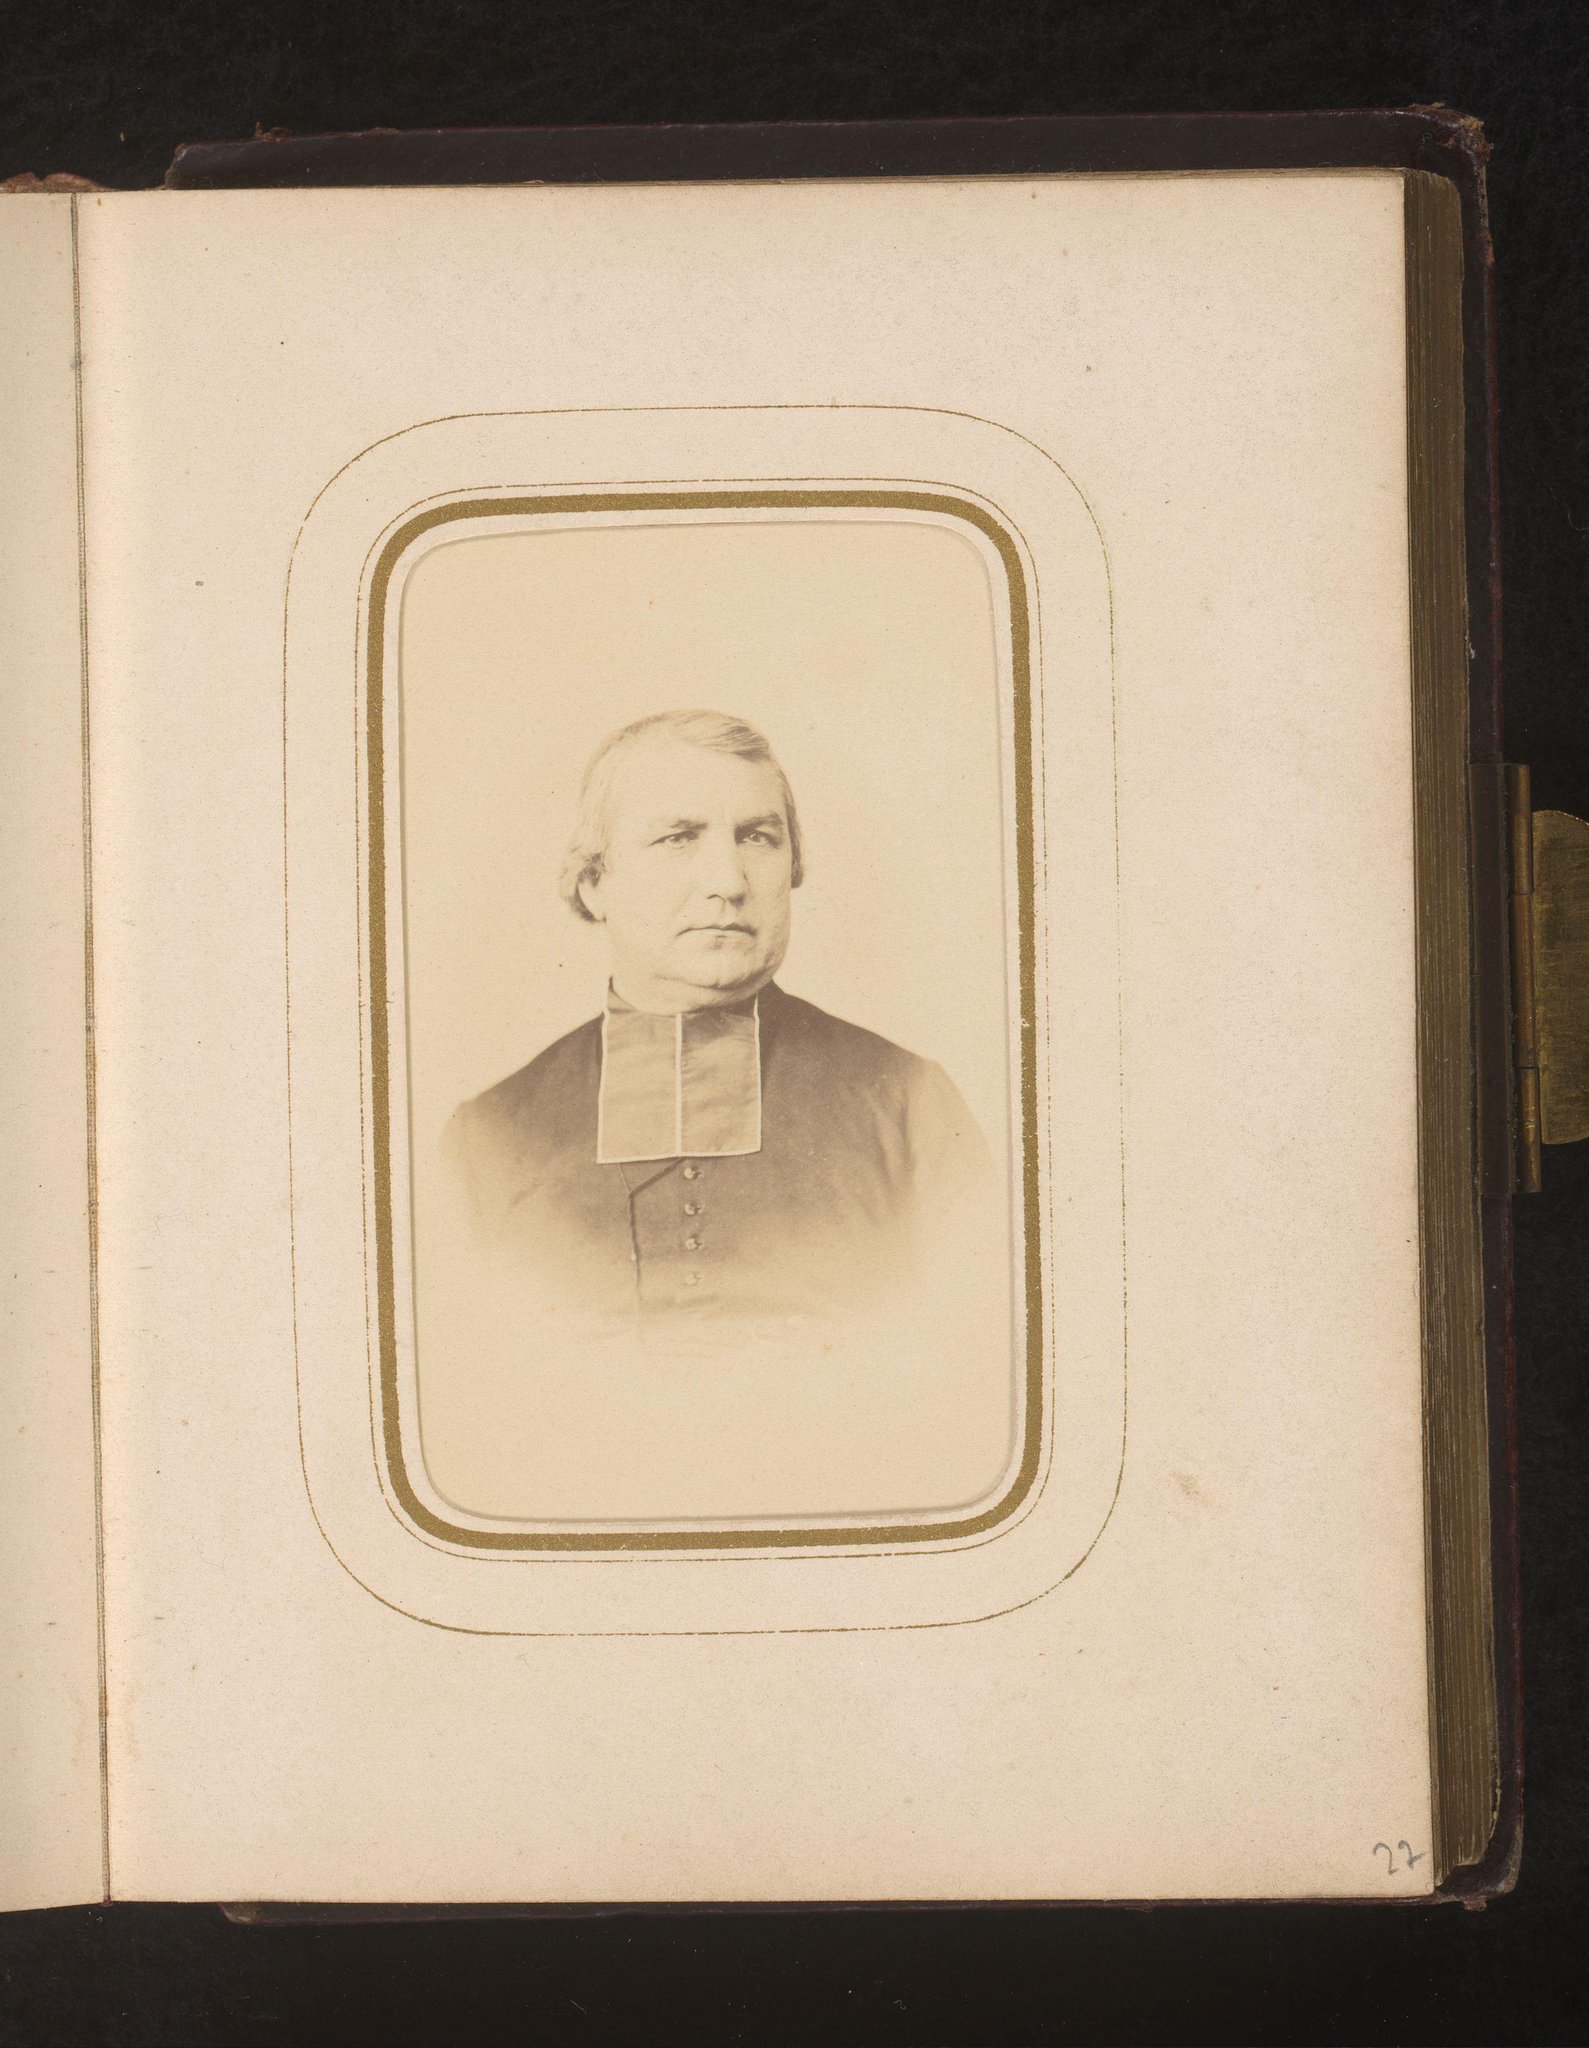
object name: carte de visite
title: Portret van een geestelijke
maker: françois marie louis franck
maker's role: fotograaf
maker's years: 1816-1906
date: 1867-1900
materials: cardboard, photographic support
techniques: albumen print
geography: geneva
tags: historical persons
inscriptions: inscription: ‘Photographie Franck/ médailles/ France 1867 (...)/ Rue Vivienne 18/ au Deuxième Etage/ Paris’